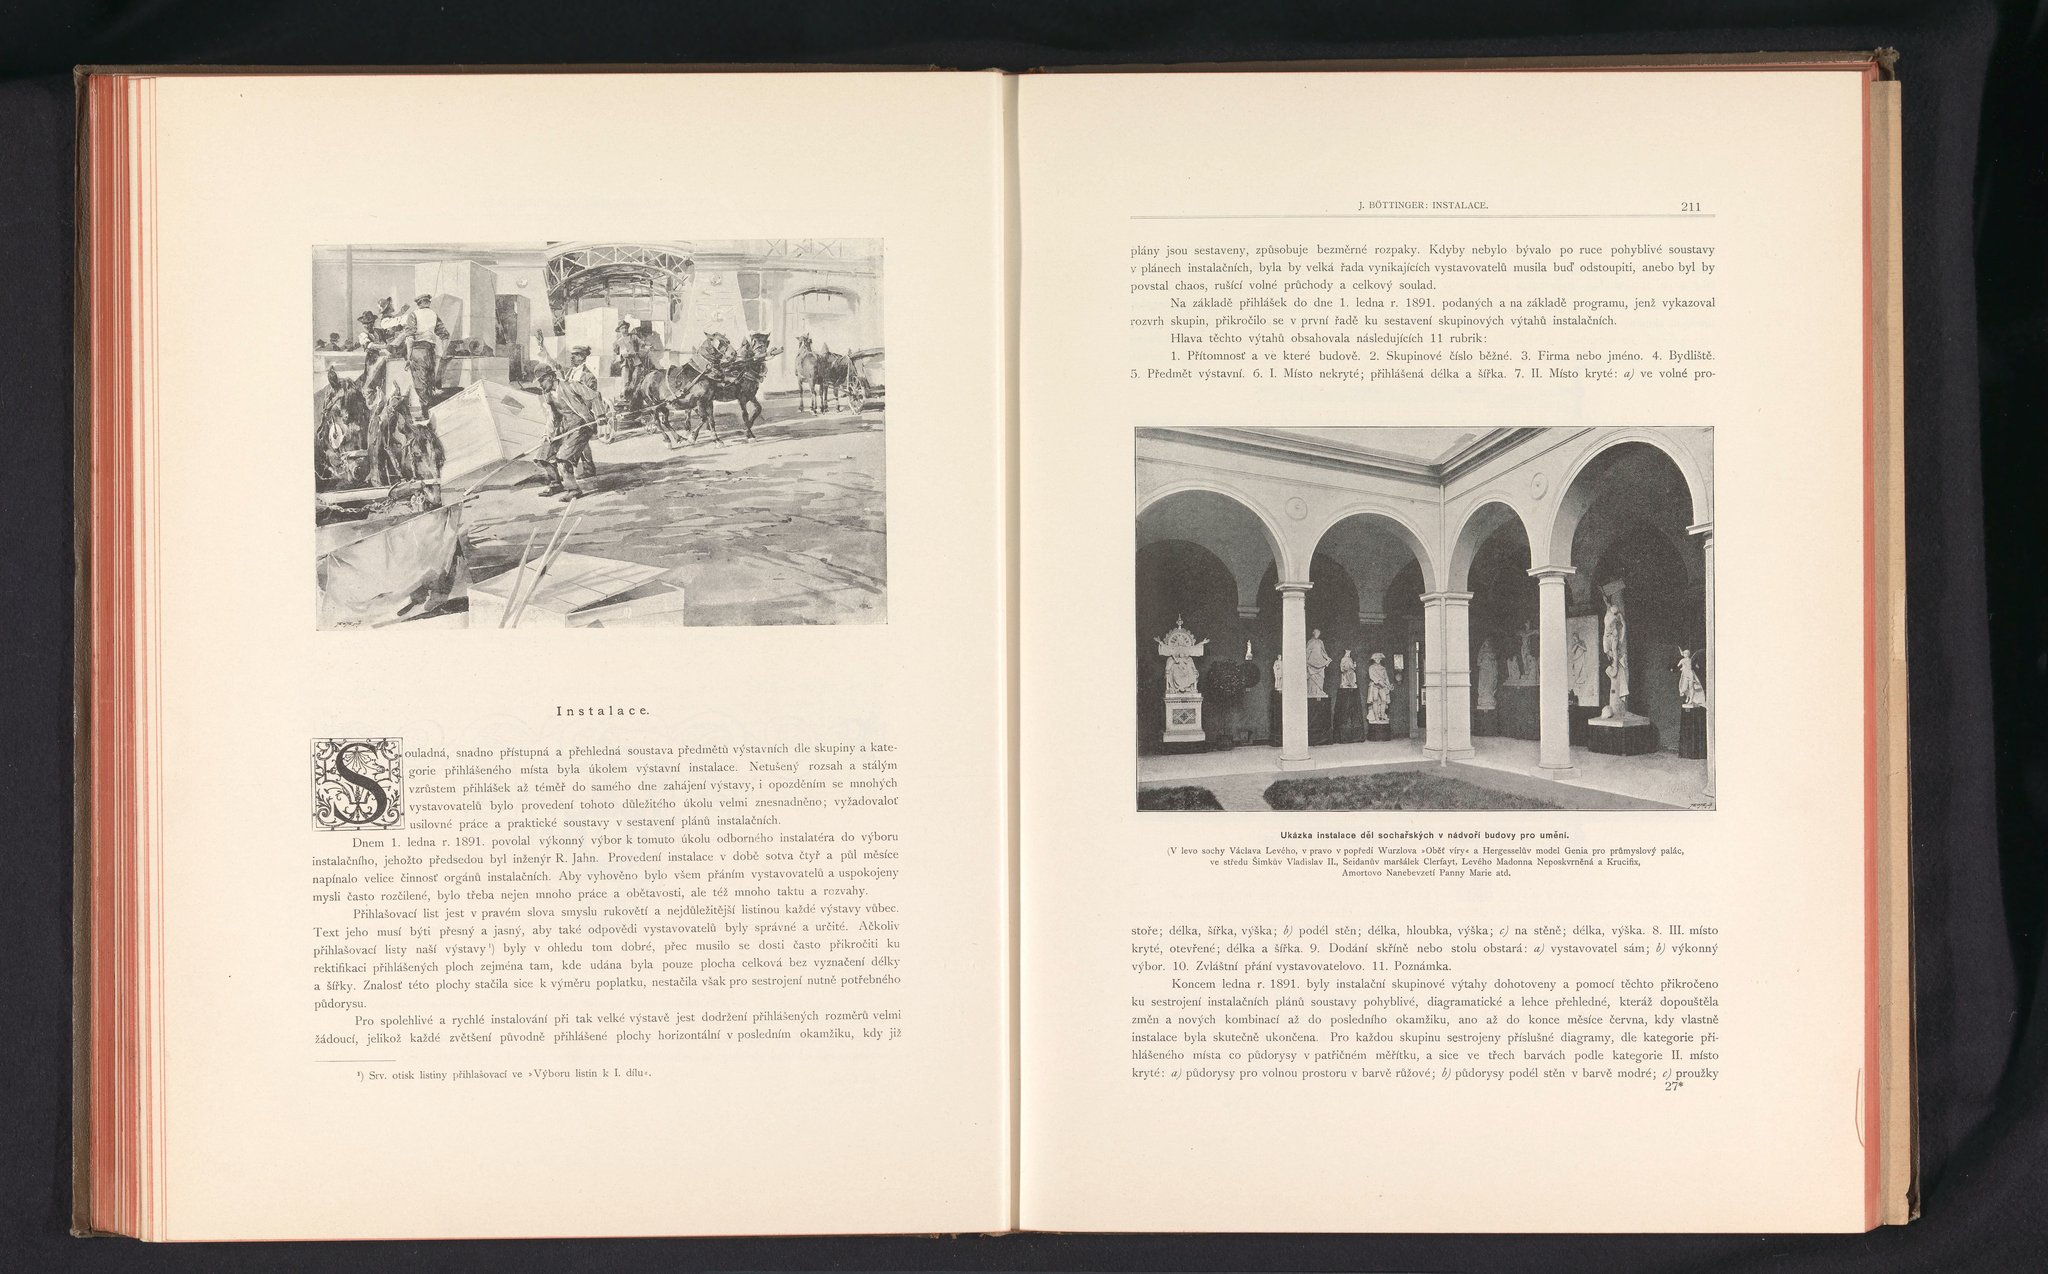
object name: page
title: Fotoreproductie van een tekening, voorstellende mannen verplaatsen vracht met paardenkarren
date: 1891-1893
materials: paper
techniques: autotype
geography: výstaviště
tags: containers, (farm) wagon, freight wagon, cart